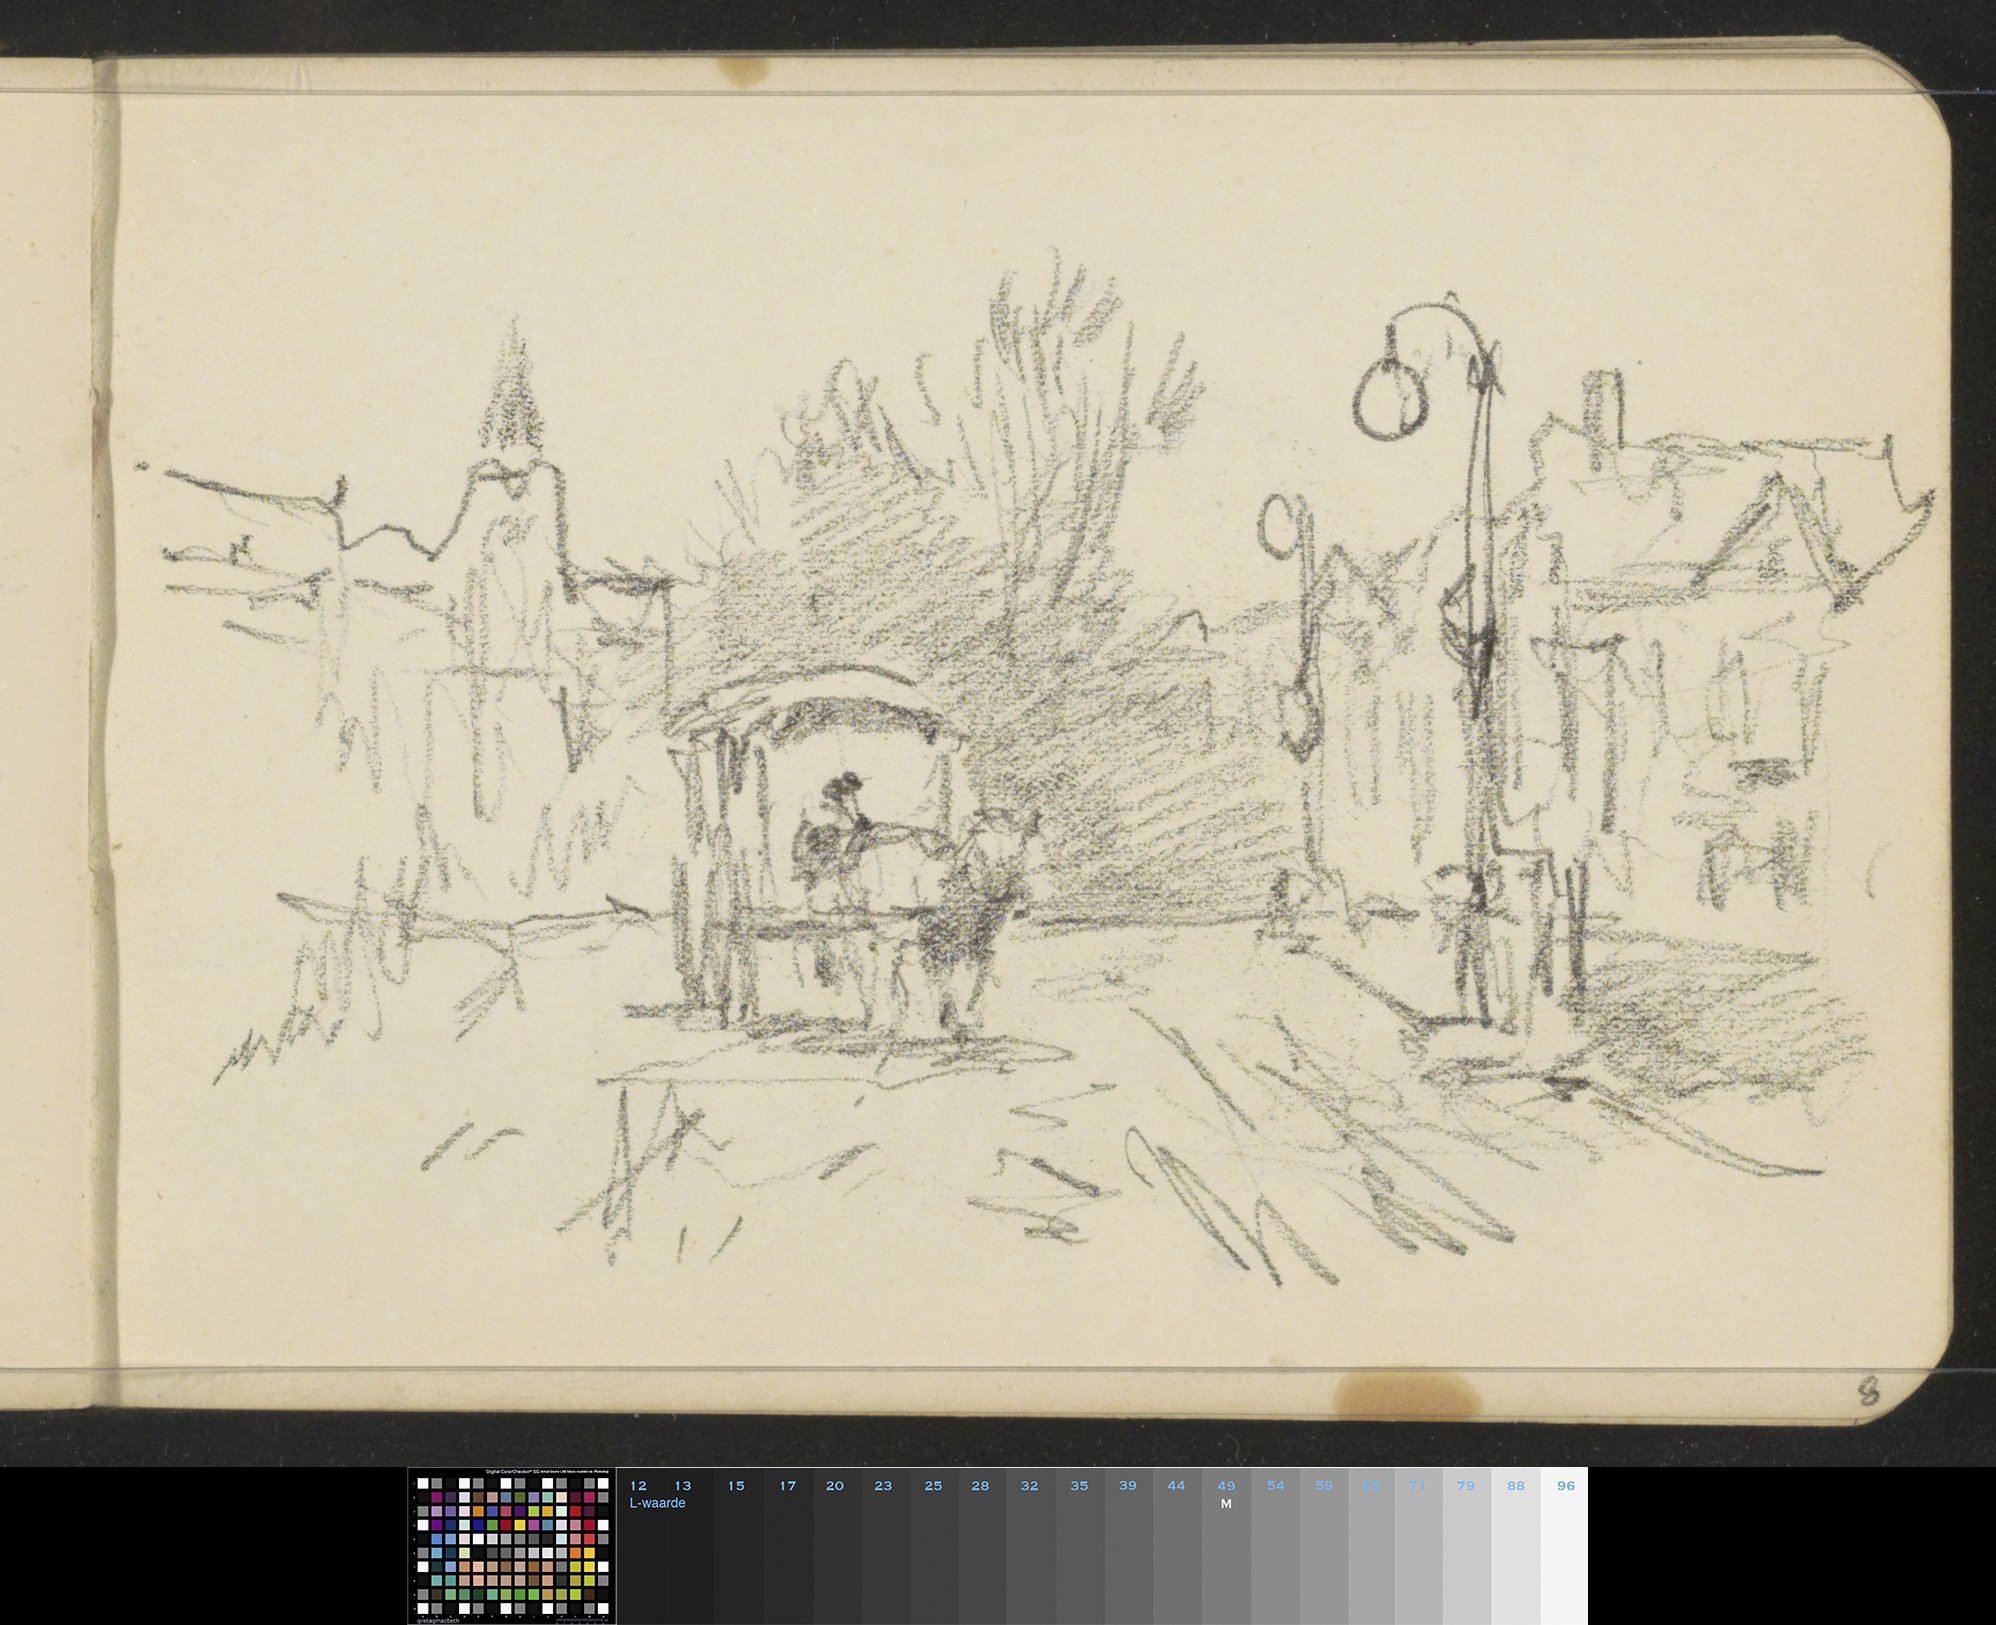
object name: sketchbook leaf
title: Huifkar op een straat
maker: willem cornelis rip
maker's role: draughtsman, painter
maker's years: 1856-1922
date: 1914-1916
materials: chalk, paper, pencil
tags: covered wagon, hooded wagon, street lighting, street (+ city(-scape) with figures, staffage)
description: Blad 8 recto uit een schetsboek met 41 bladen.